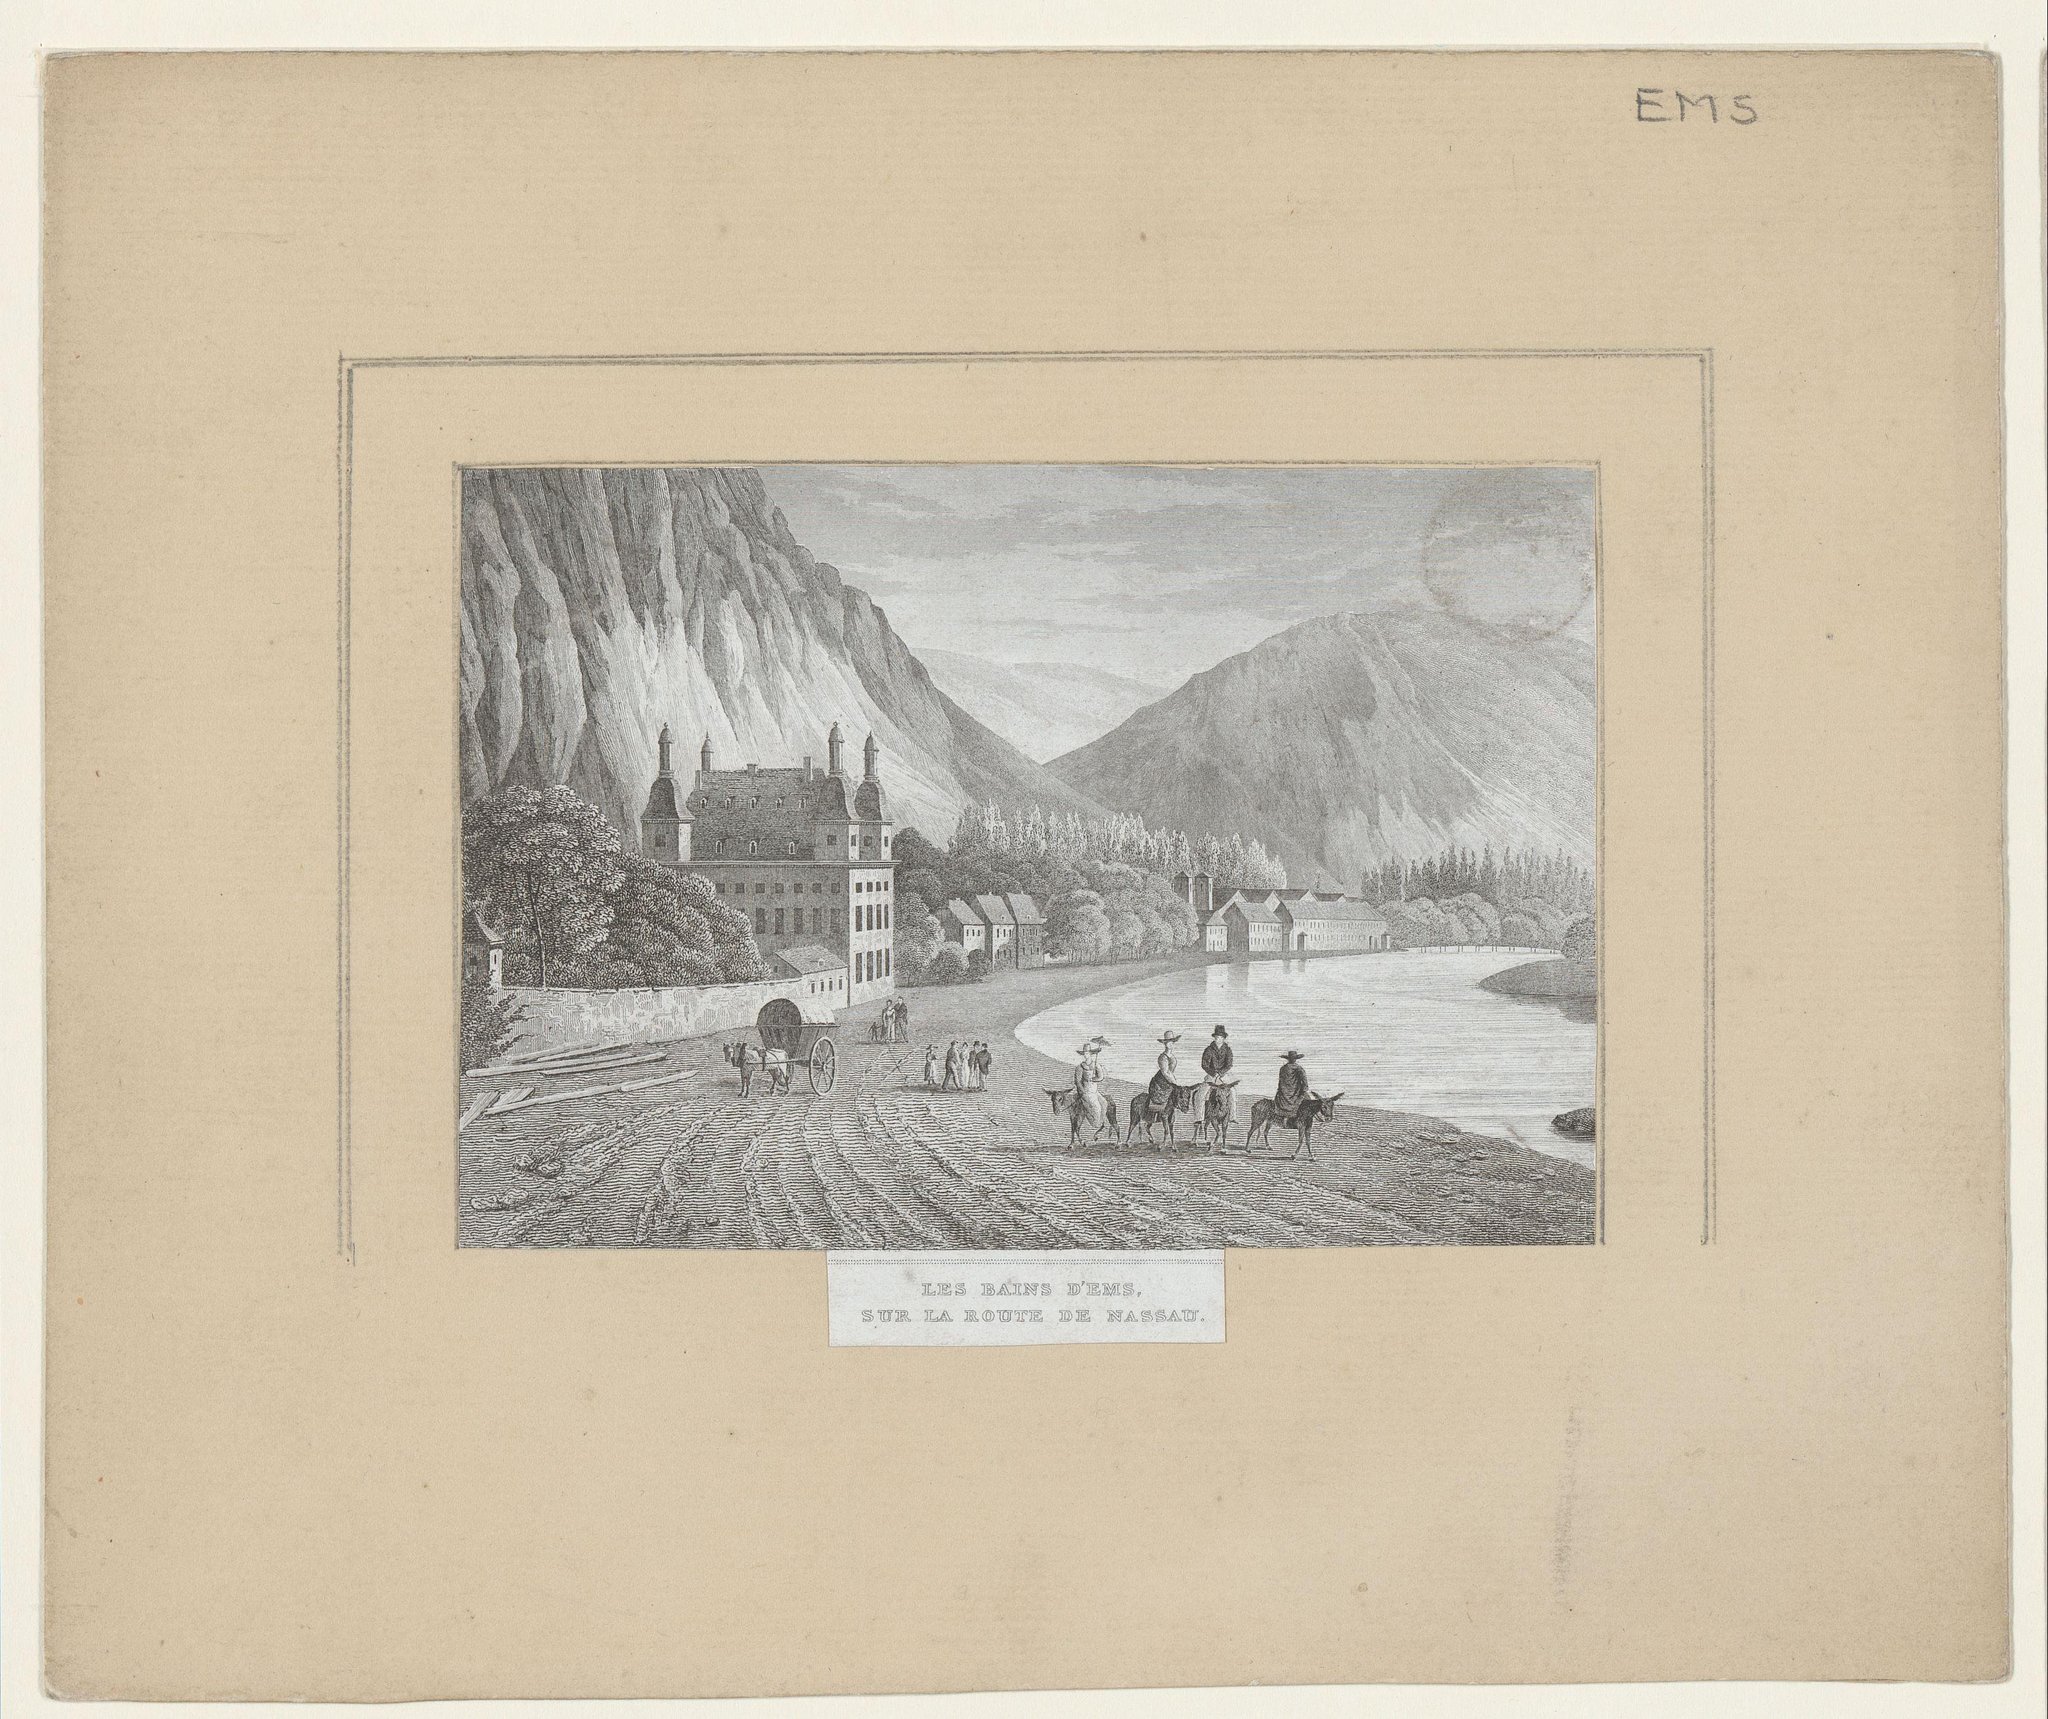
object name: print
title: Les bains d'Ems sur la route de Nassau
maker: Anonymous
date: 1800-1899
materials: paper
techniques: etching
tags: prospect of village, silhouette of village, river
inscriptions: collector's mark: Lugt 2228